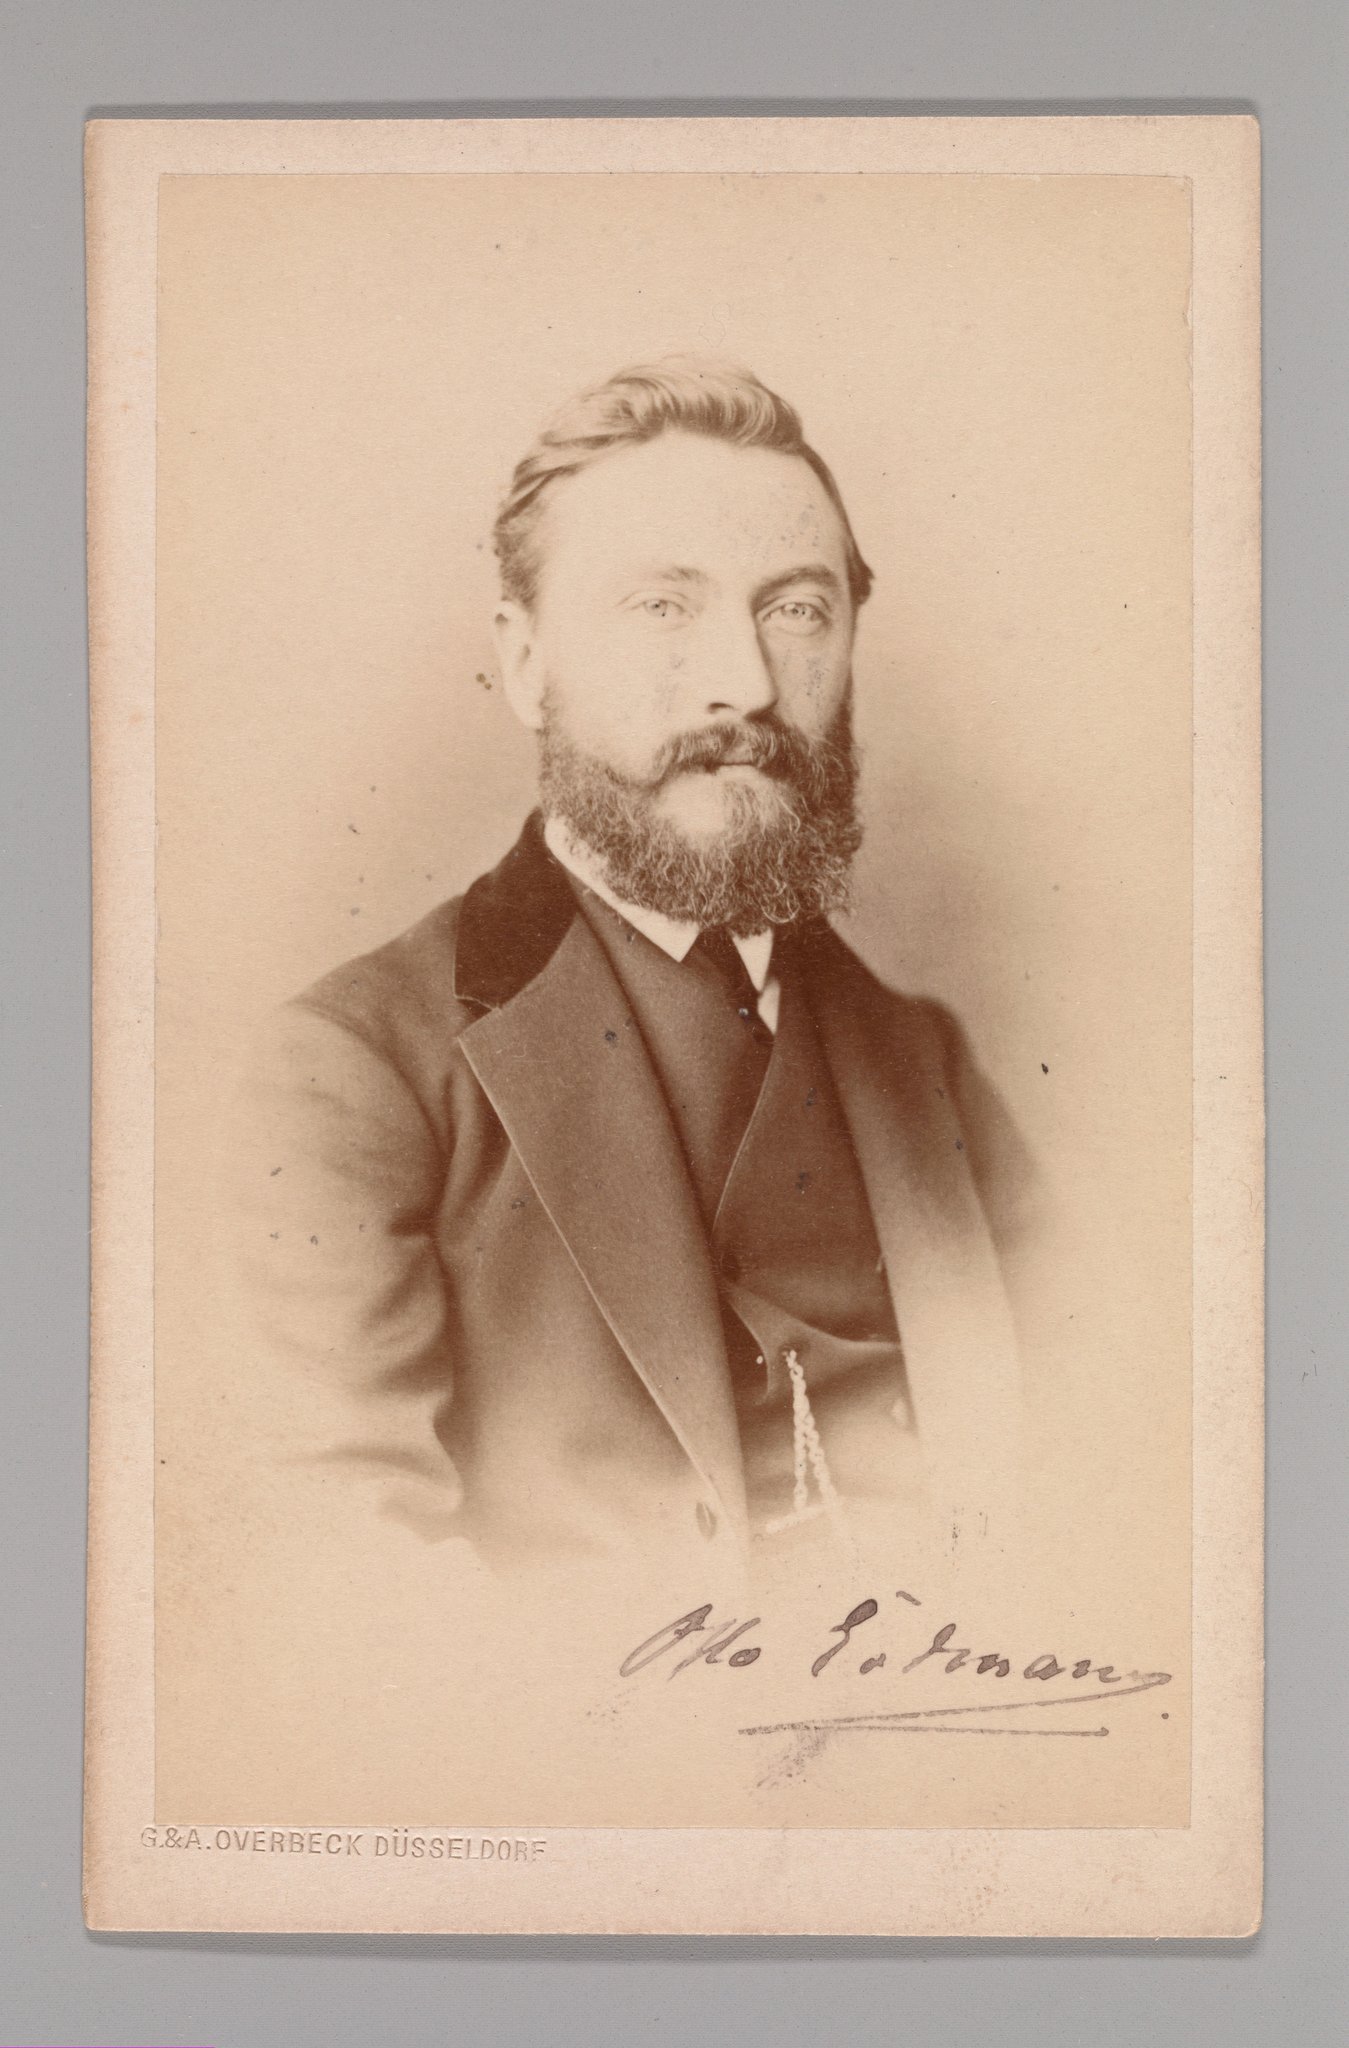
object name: carte de visite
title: [Otto Wilhelm Eduard Erdmann]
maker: g. & a. overbeck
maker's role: photography studio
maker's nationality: german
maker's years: 1855-1870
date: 1860-1869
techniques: albumen silver print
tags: men,portraits